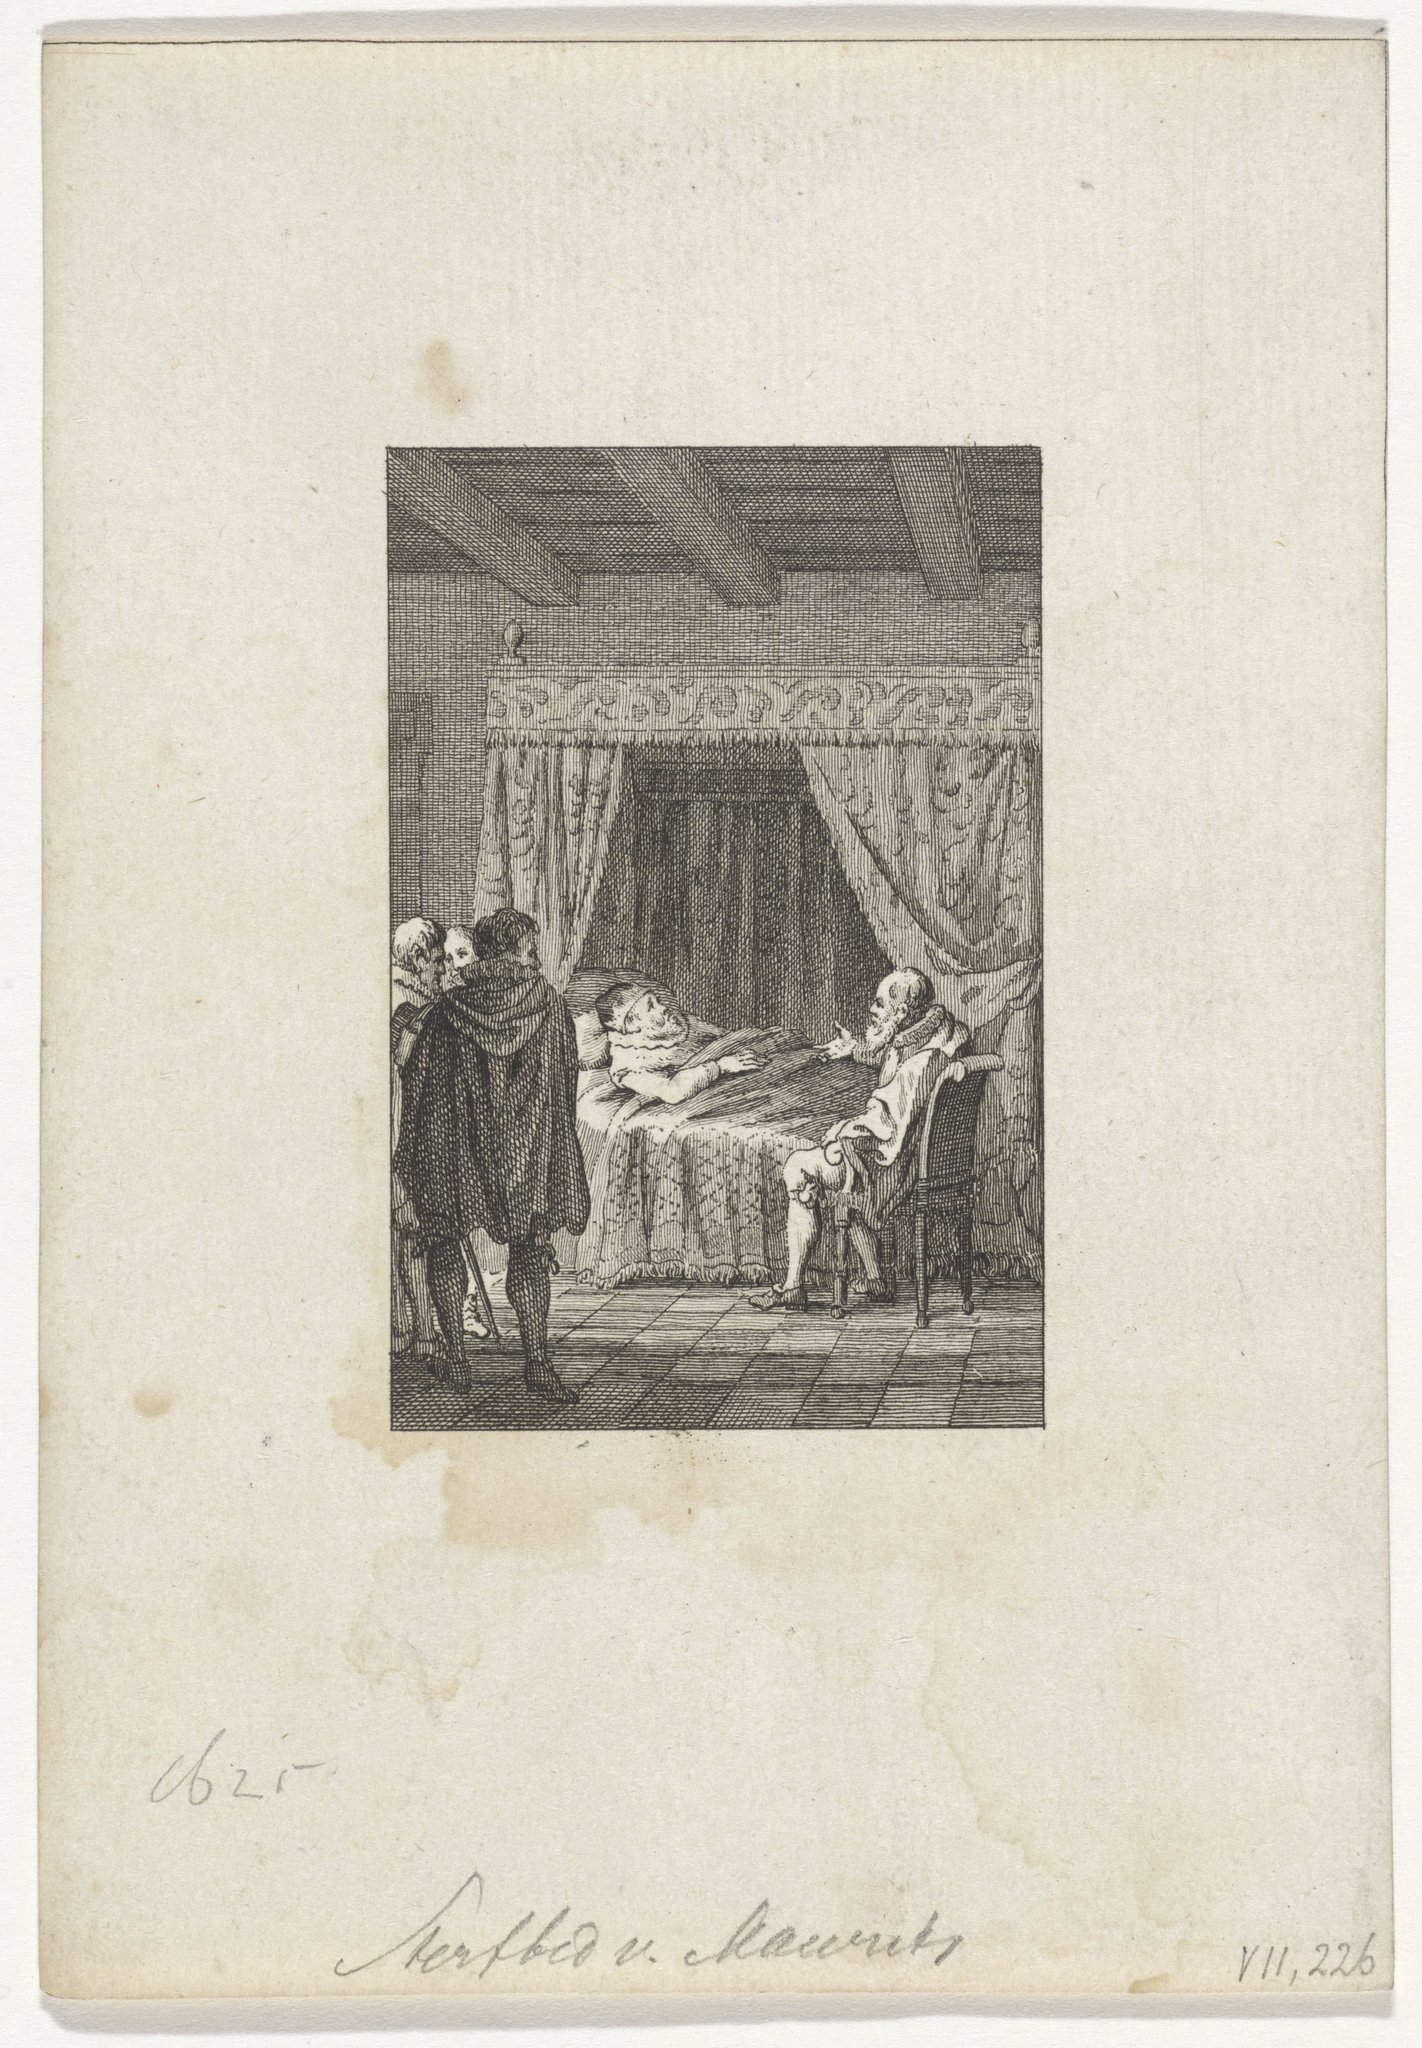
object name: print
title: Sterfbed van Prins Maurits, 1625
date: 1783-1795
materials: paper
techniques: etching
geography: amsterdam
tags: the hague, maurice (prince of orange), deathbed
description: Illustratie voor: J. Fokke. Geschiedenissen der Vereenigde Nederlanden voor de vaderlandsche jeugd. Amsterdam: Johannes Allart, 1783-1795, 25 delen. deel VII pl. VI.